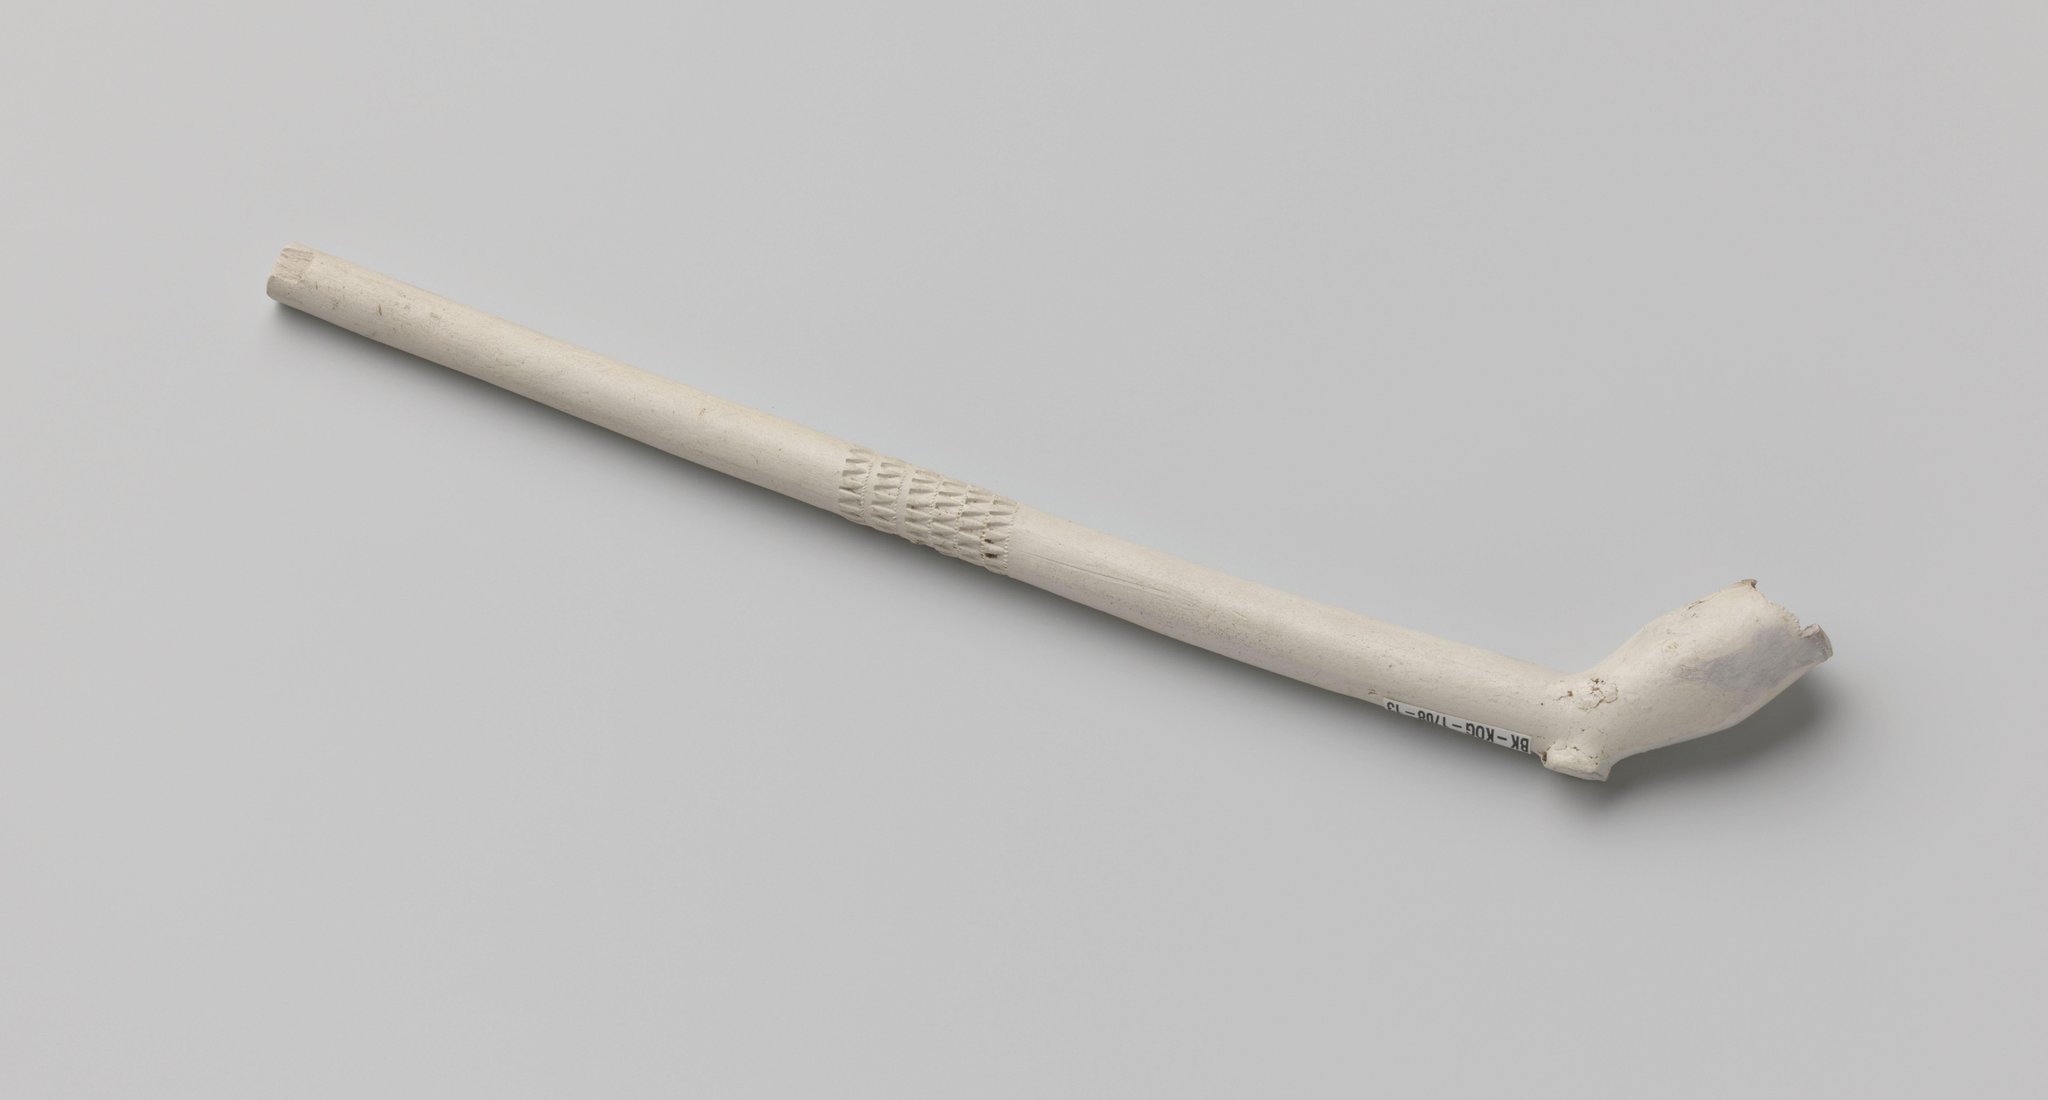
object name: tabakspijp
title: Gemerkte tabakspijp van pijpaarde, beschadigd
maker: Anonymous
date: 1500-1799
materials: clay